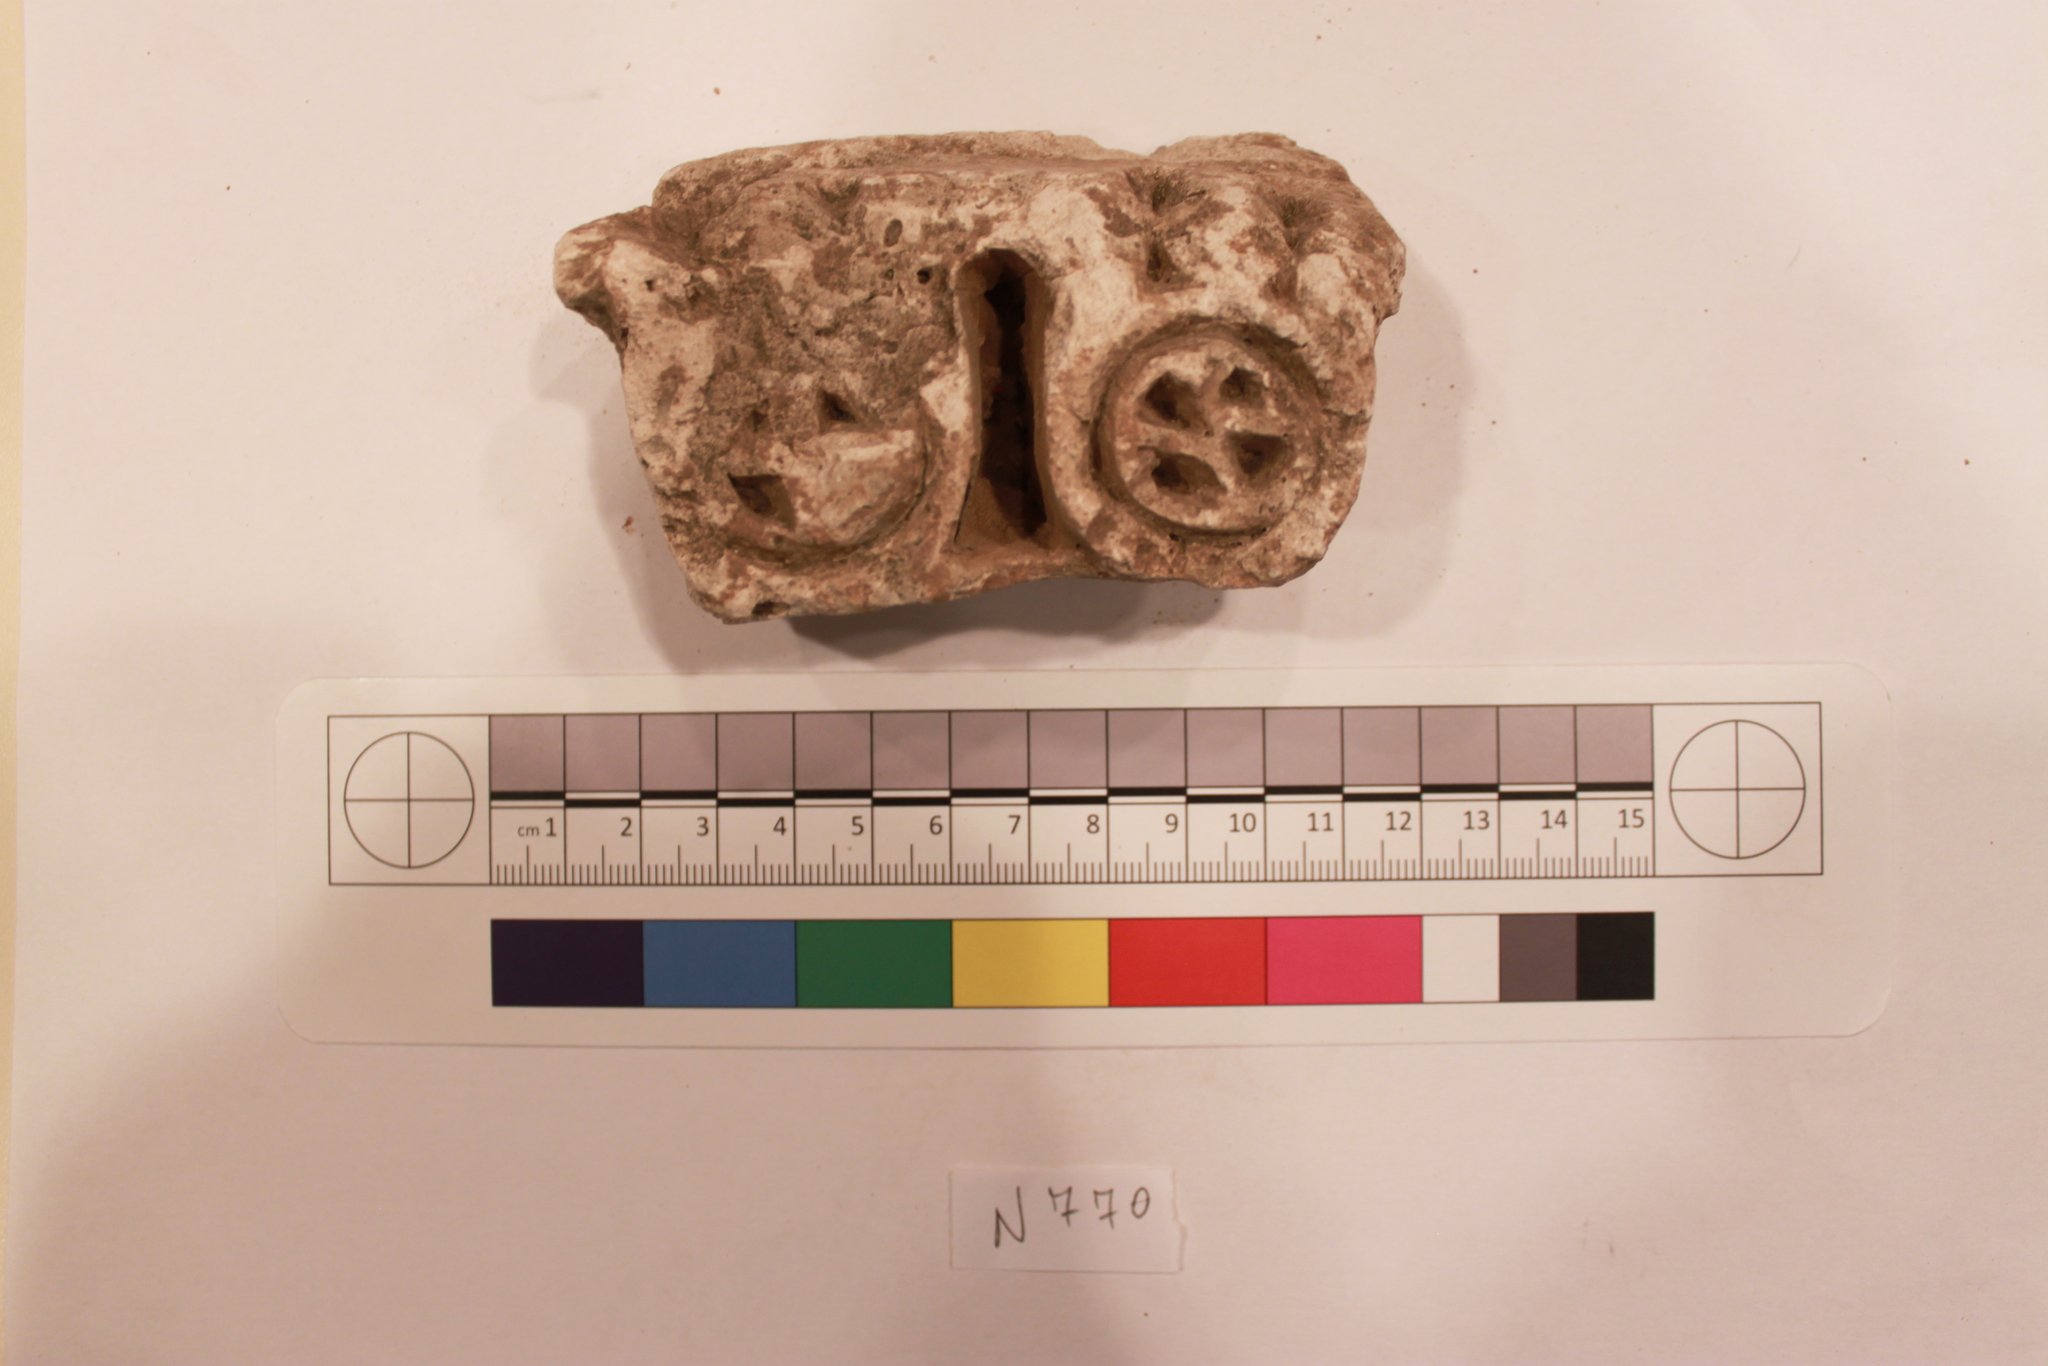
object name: fragment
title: Stucco Fragment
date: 701-1200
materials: plaster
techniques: carving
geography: iran